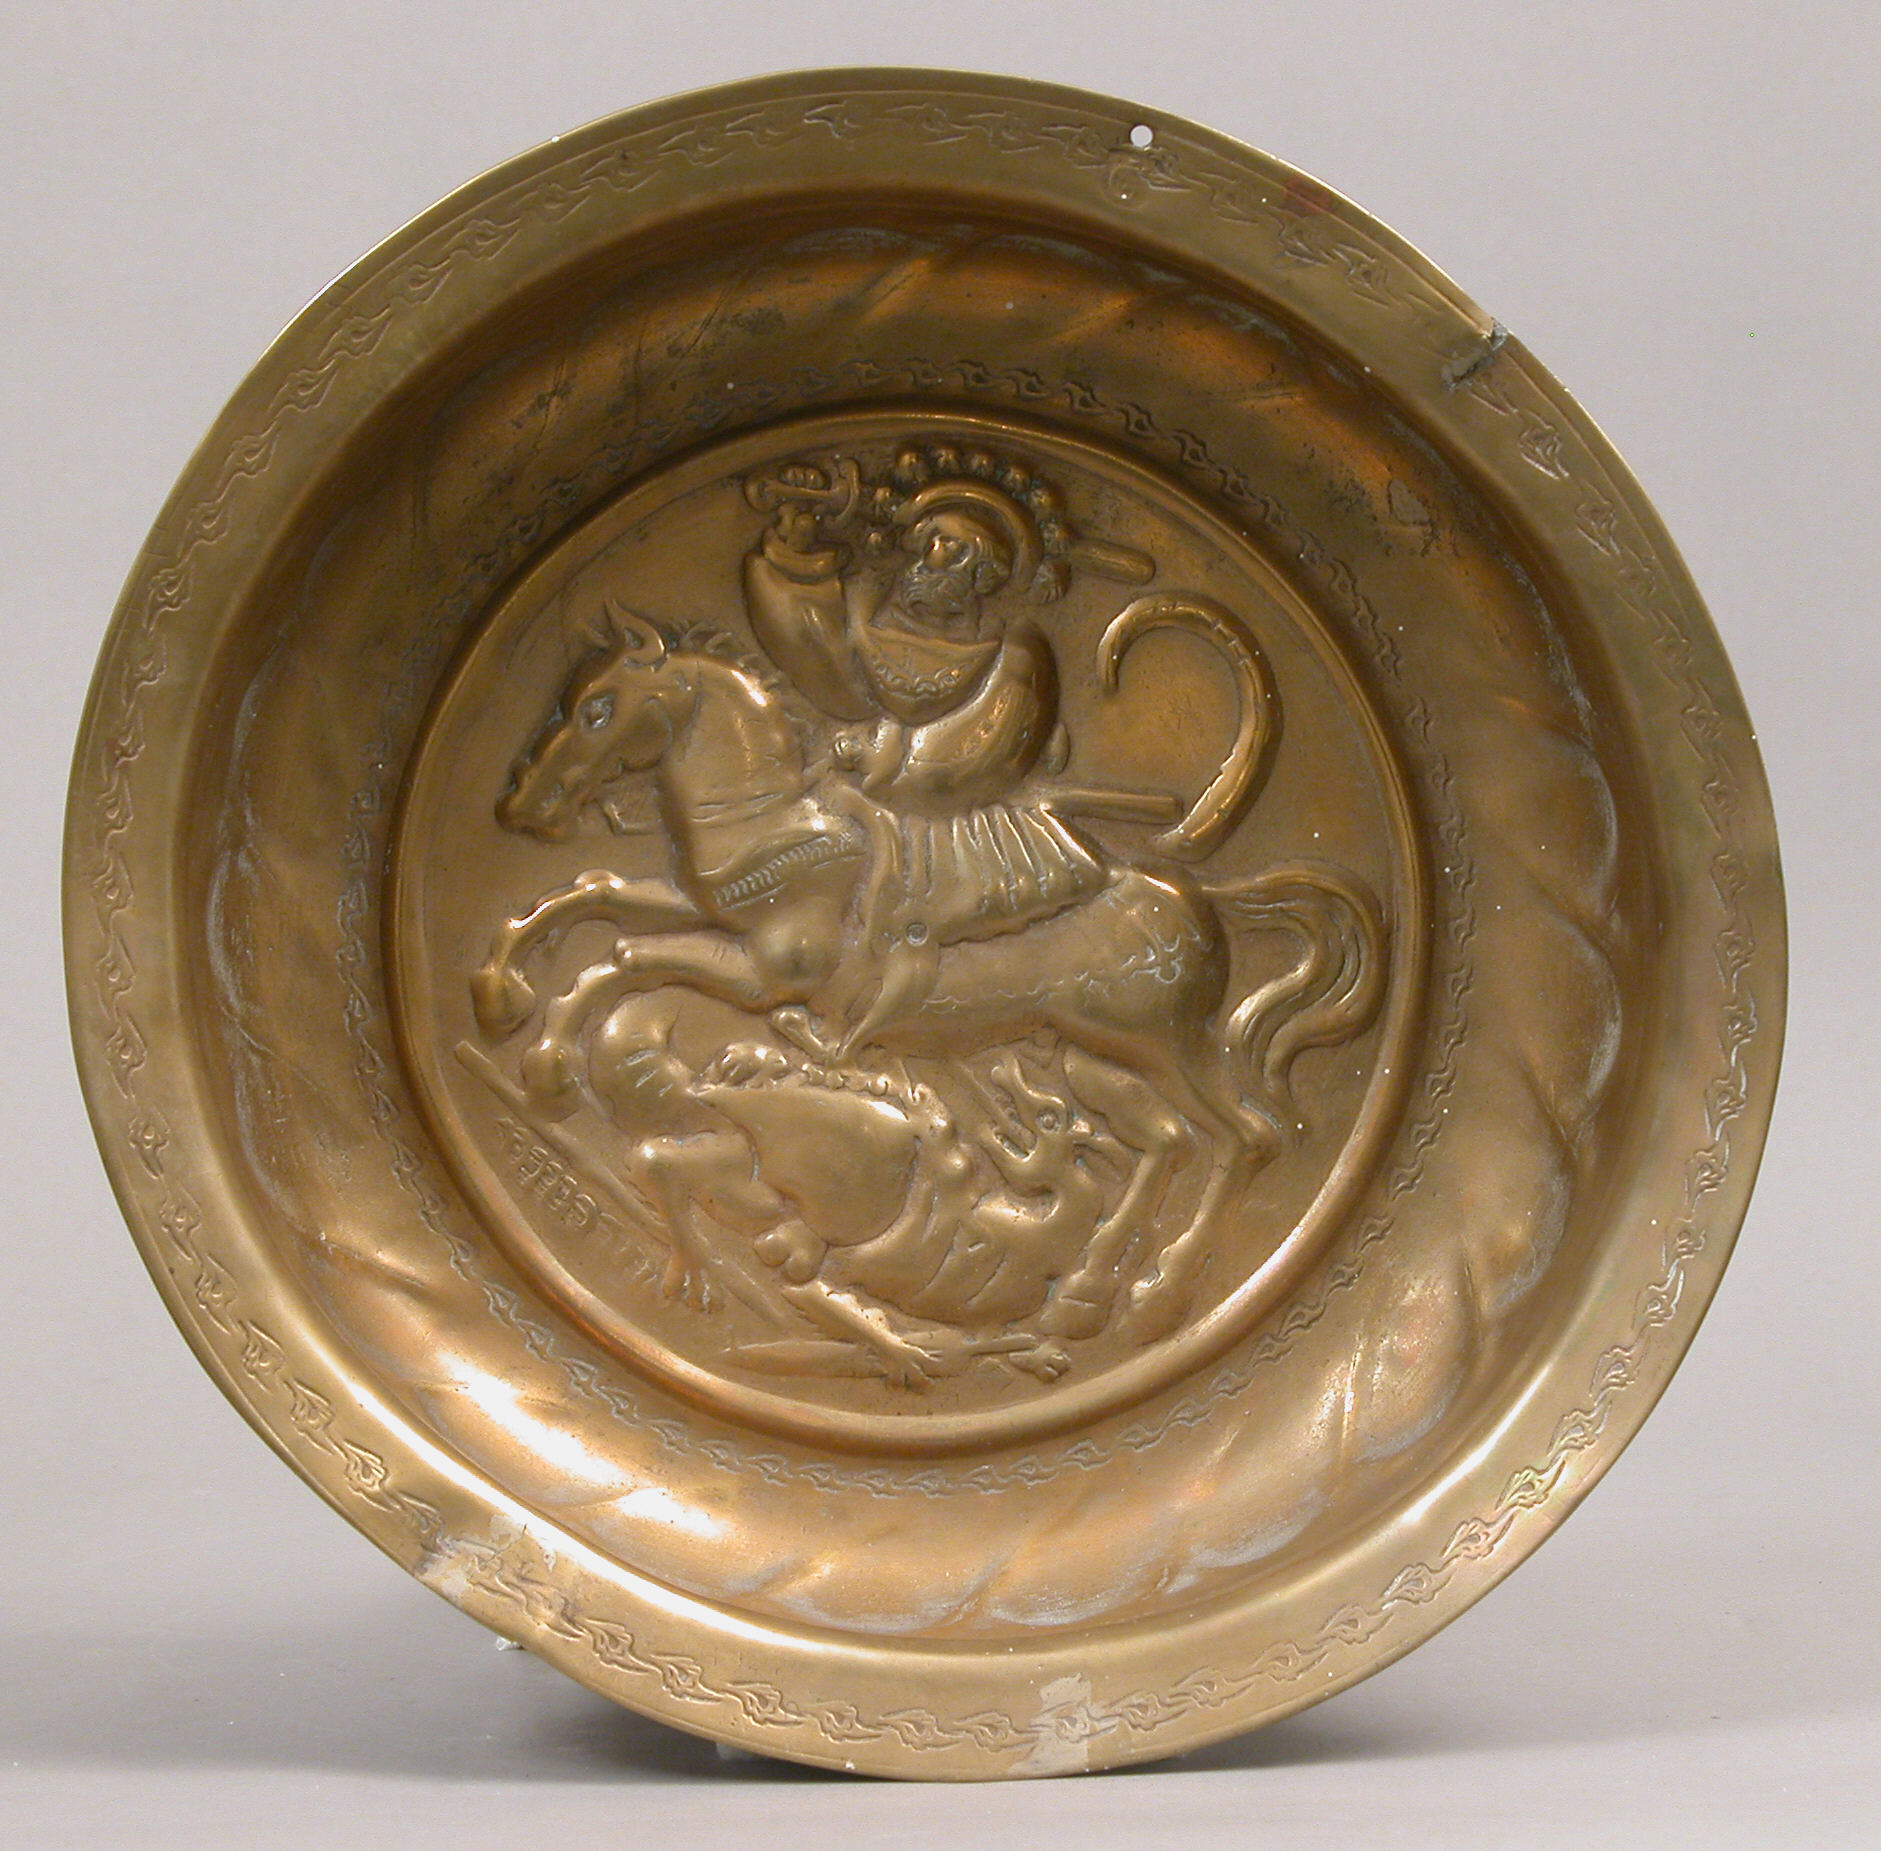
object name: dish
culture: german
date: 1501-1533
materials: brass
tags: dragons,horses,saints